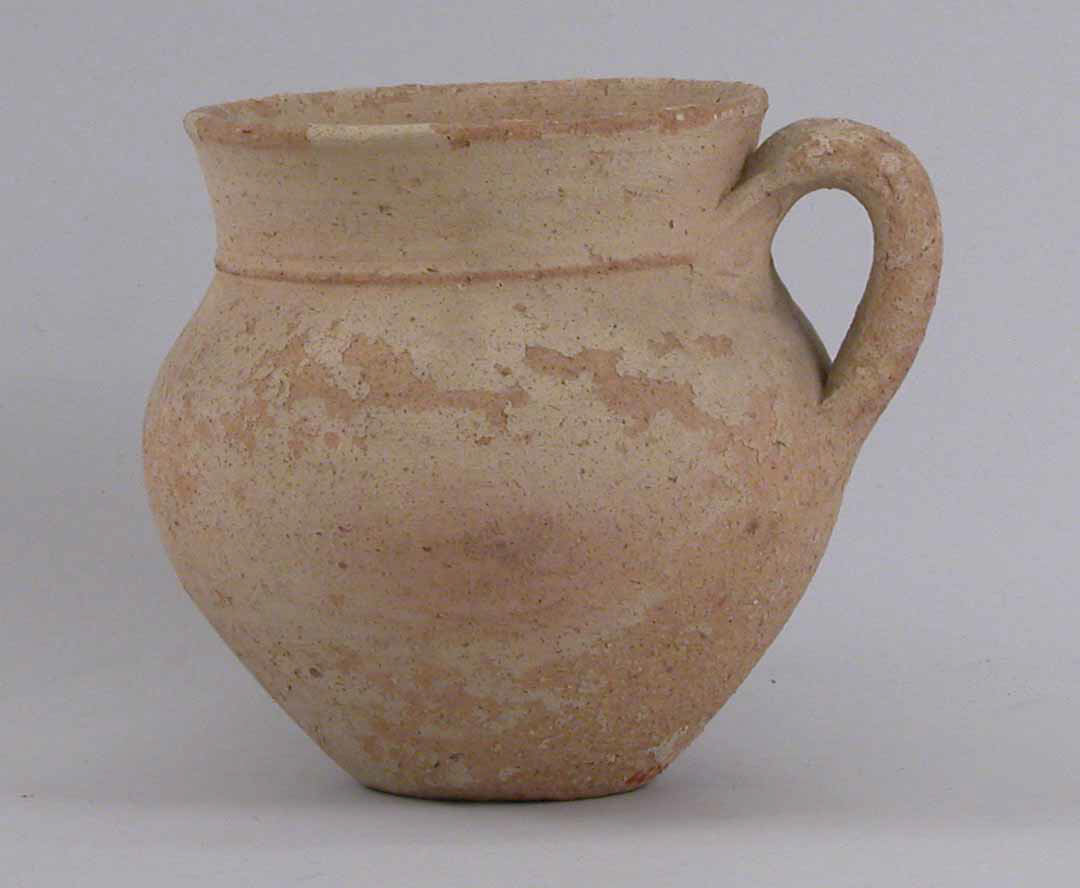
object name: cup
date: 1001-1200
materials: earthenware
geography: iran